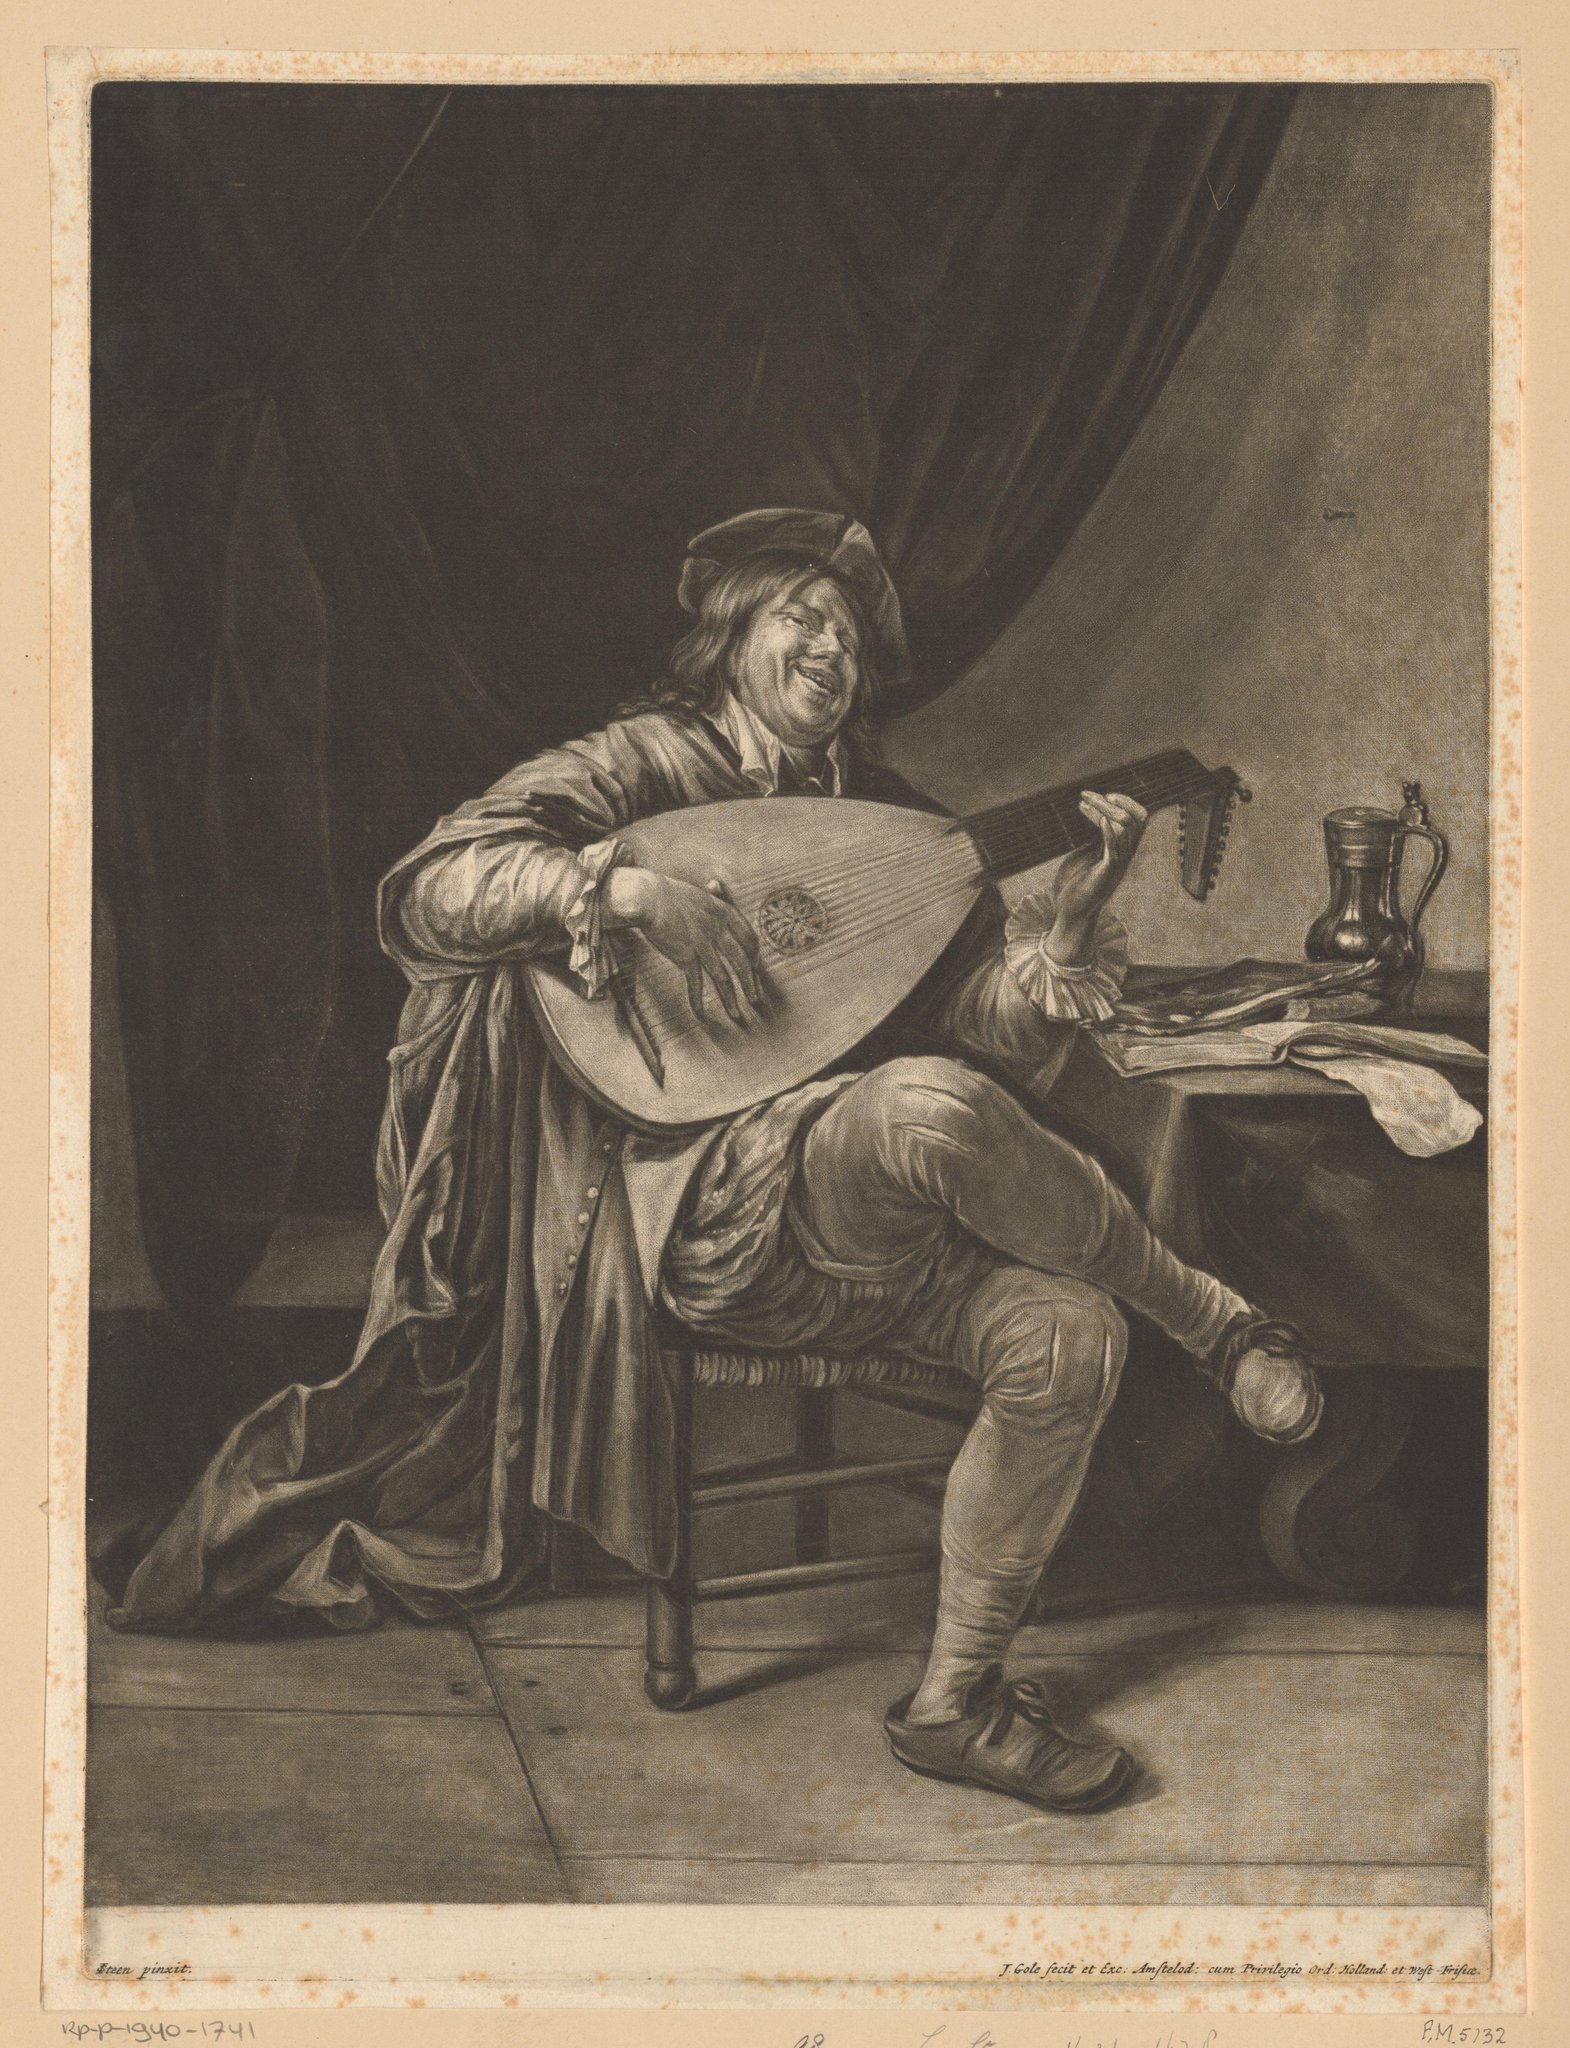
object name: print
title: Portret van Jan Havicksz. Steen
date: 1670-1724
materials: paper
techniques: mezzotint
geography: amsterdam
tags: leiden, painter, jan havicksz. steen, historical persons, portrait, self-portrait of artist, lute, and special forms of lute, e.g.: theorbo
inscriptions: collector's mark: Lugt 2228, collector's mark: Lugt 2760, collector's mark: Lugt 2166